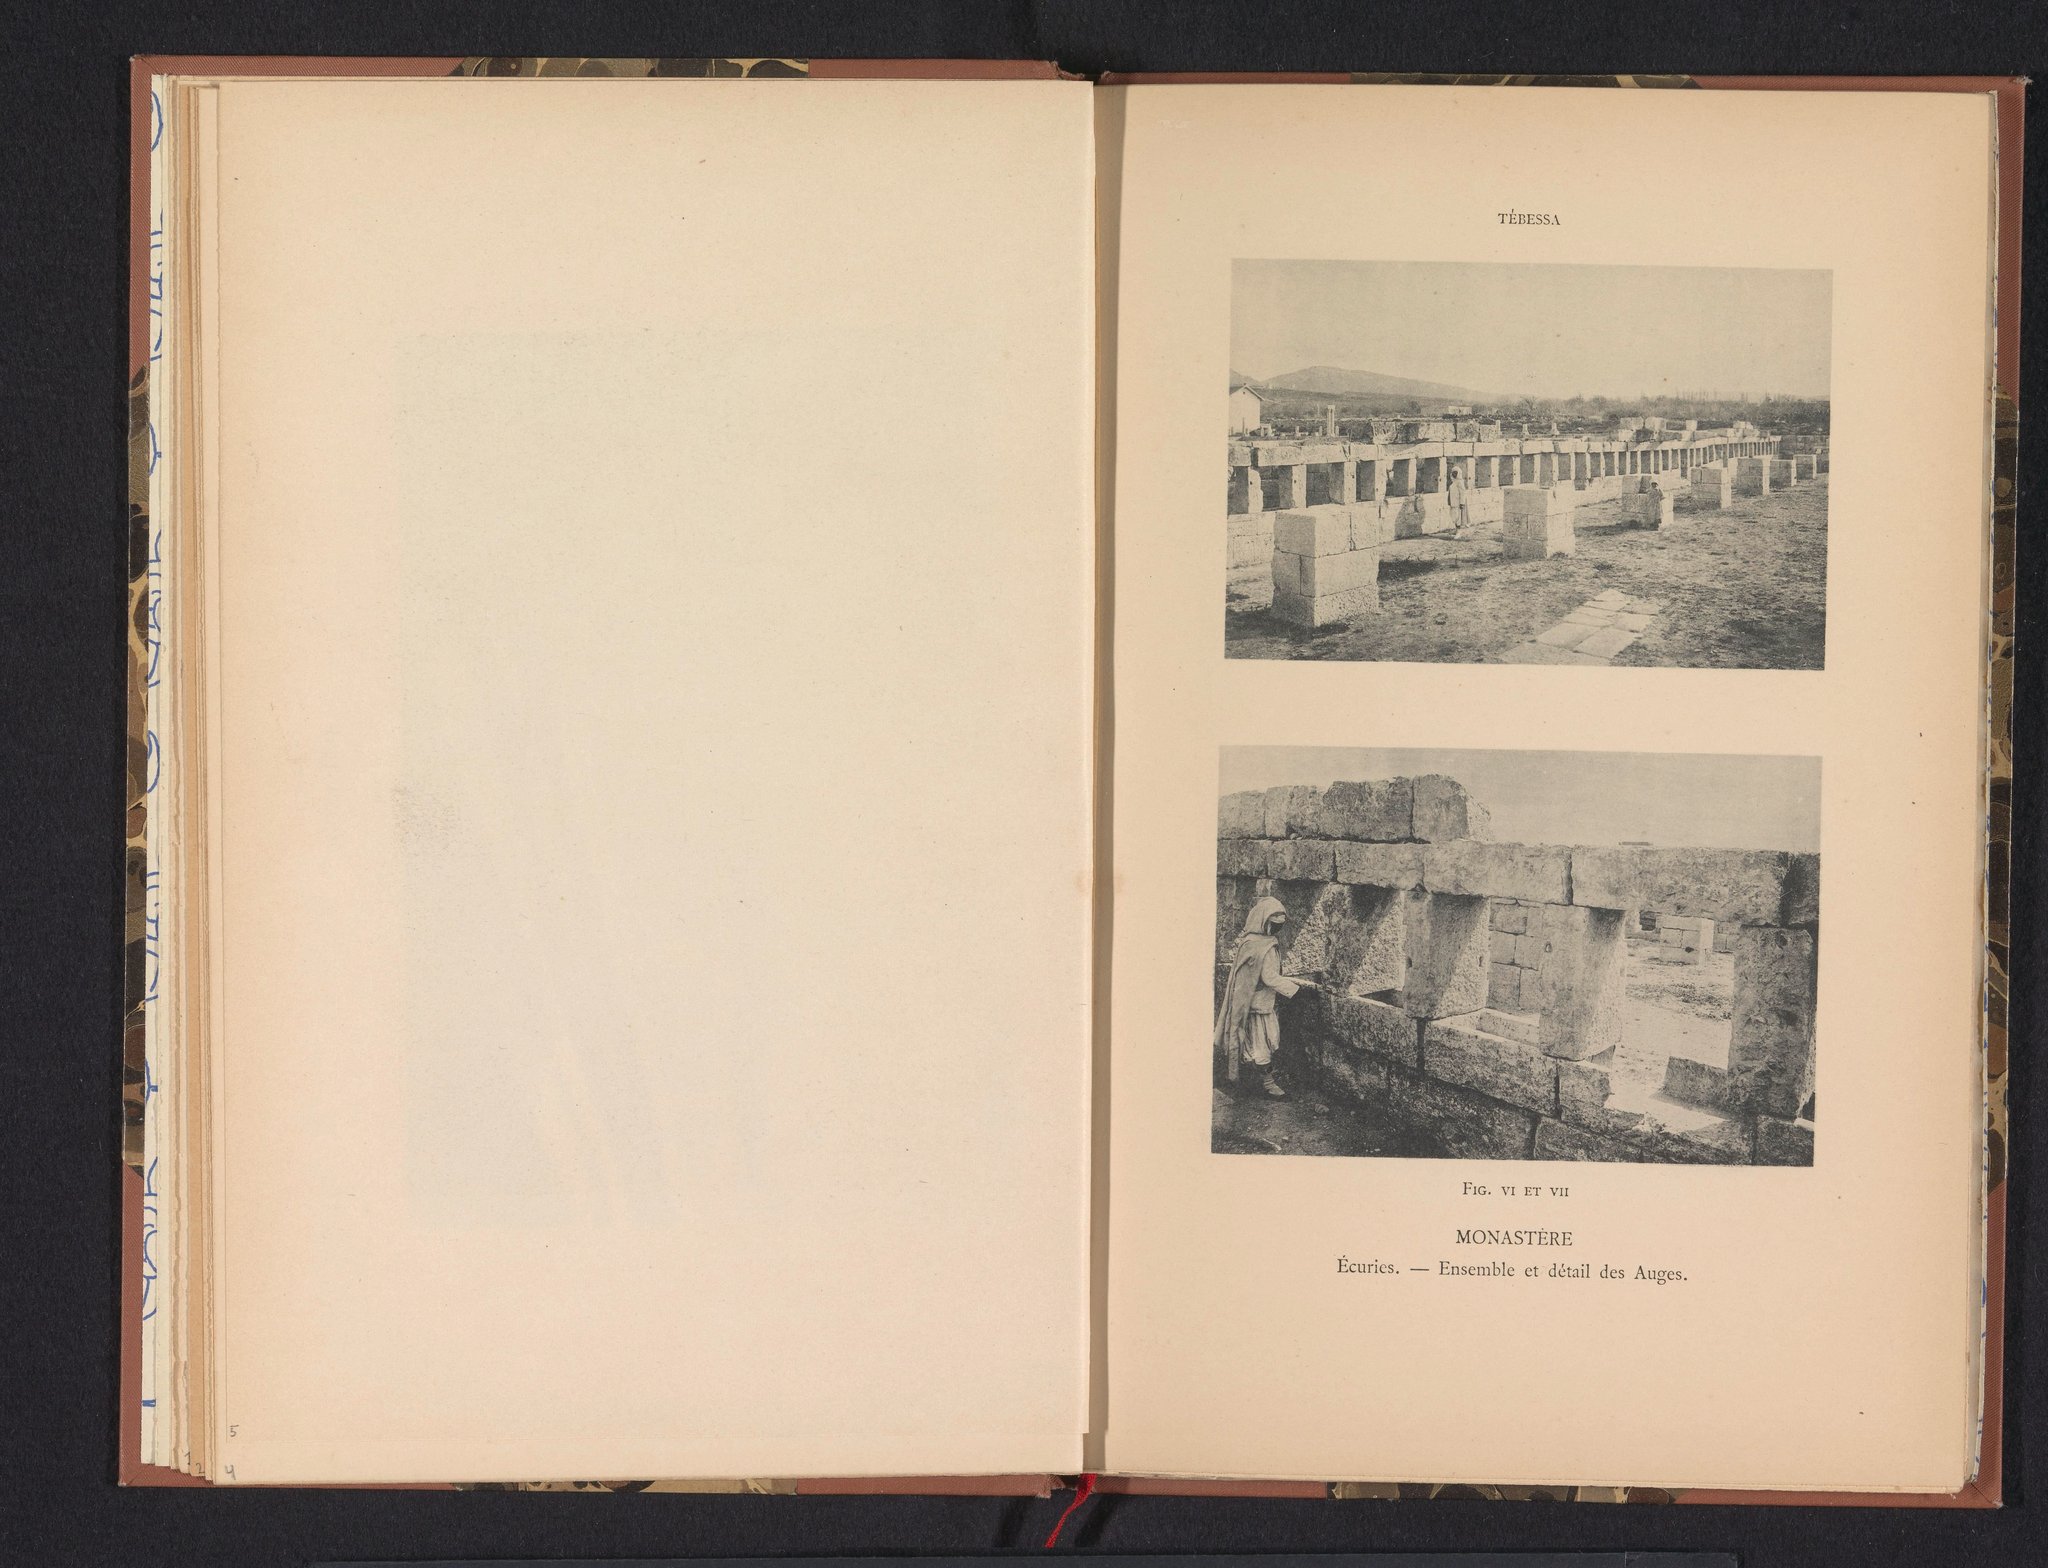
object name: photomechanical print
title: Monastère Écuries. - Ensemble et détail des Auges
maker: Anonymous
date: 1884-1894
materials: paper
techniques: photograph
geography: france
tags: ruin of church, monastery, etc., stall, stable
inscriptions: number: ‘Fig. VI et VII’